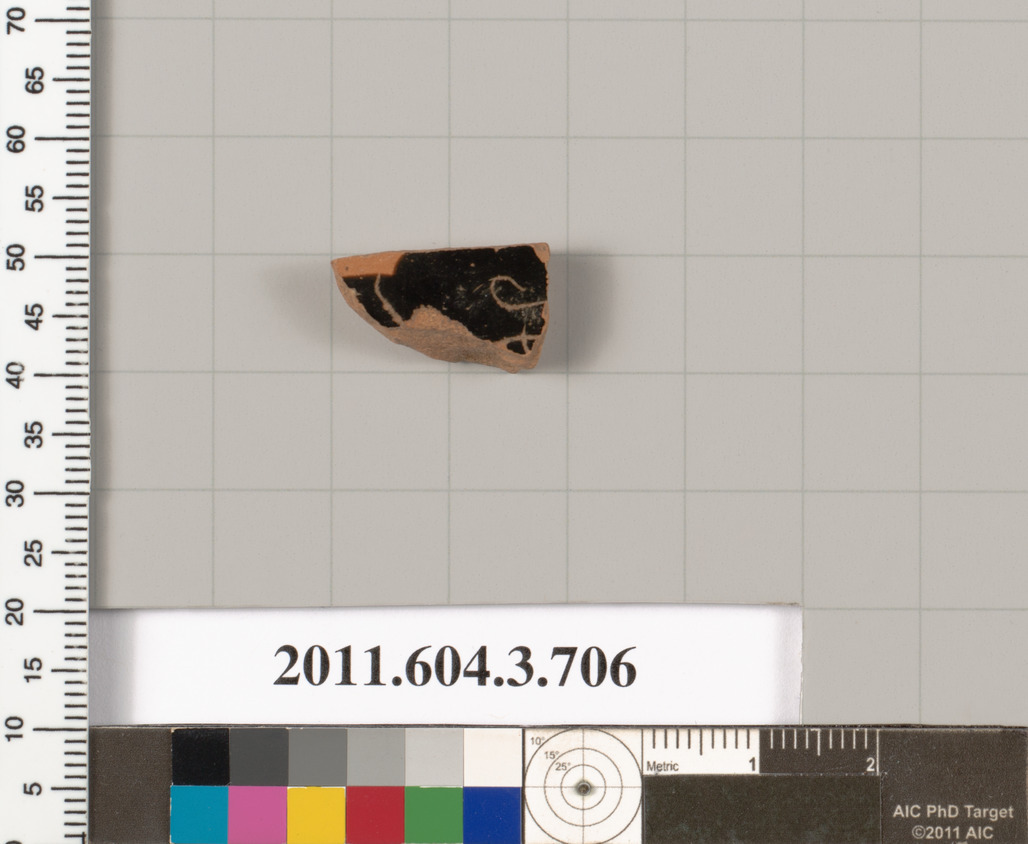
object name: hydria fragment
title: Terracotta fragment of a hydria (water jar)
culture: greek, attic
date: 534-468 BCE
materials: terracotta